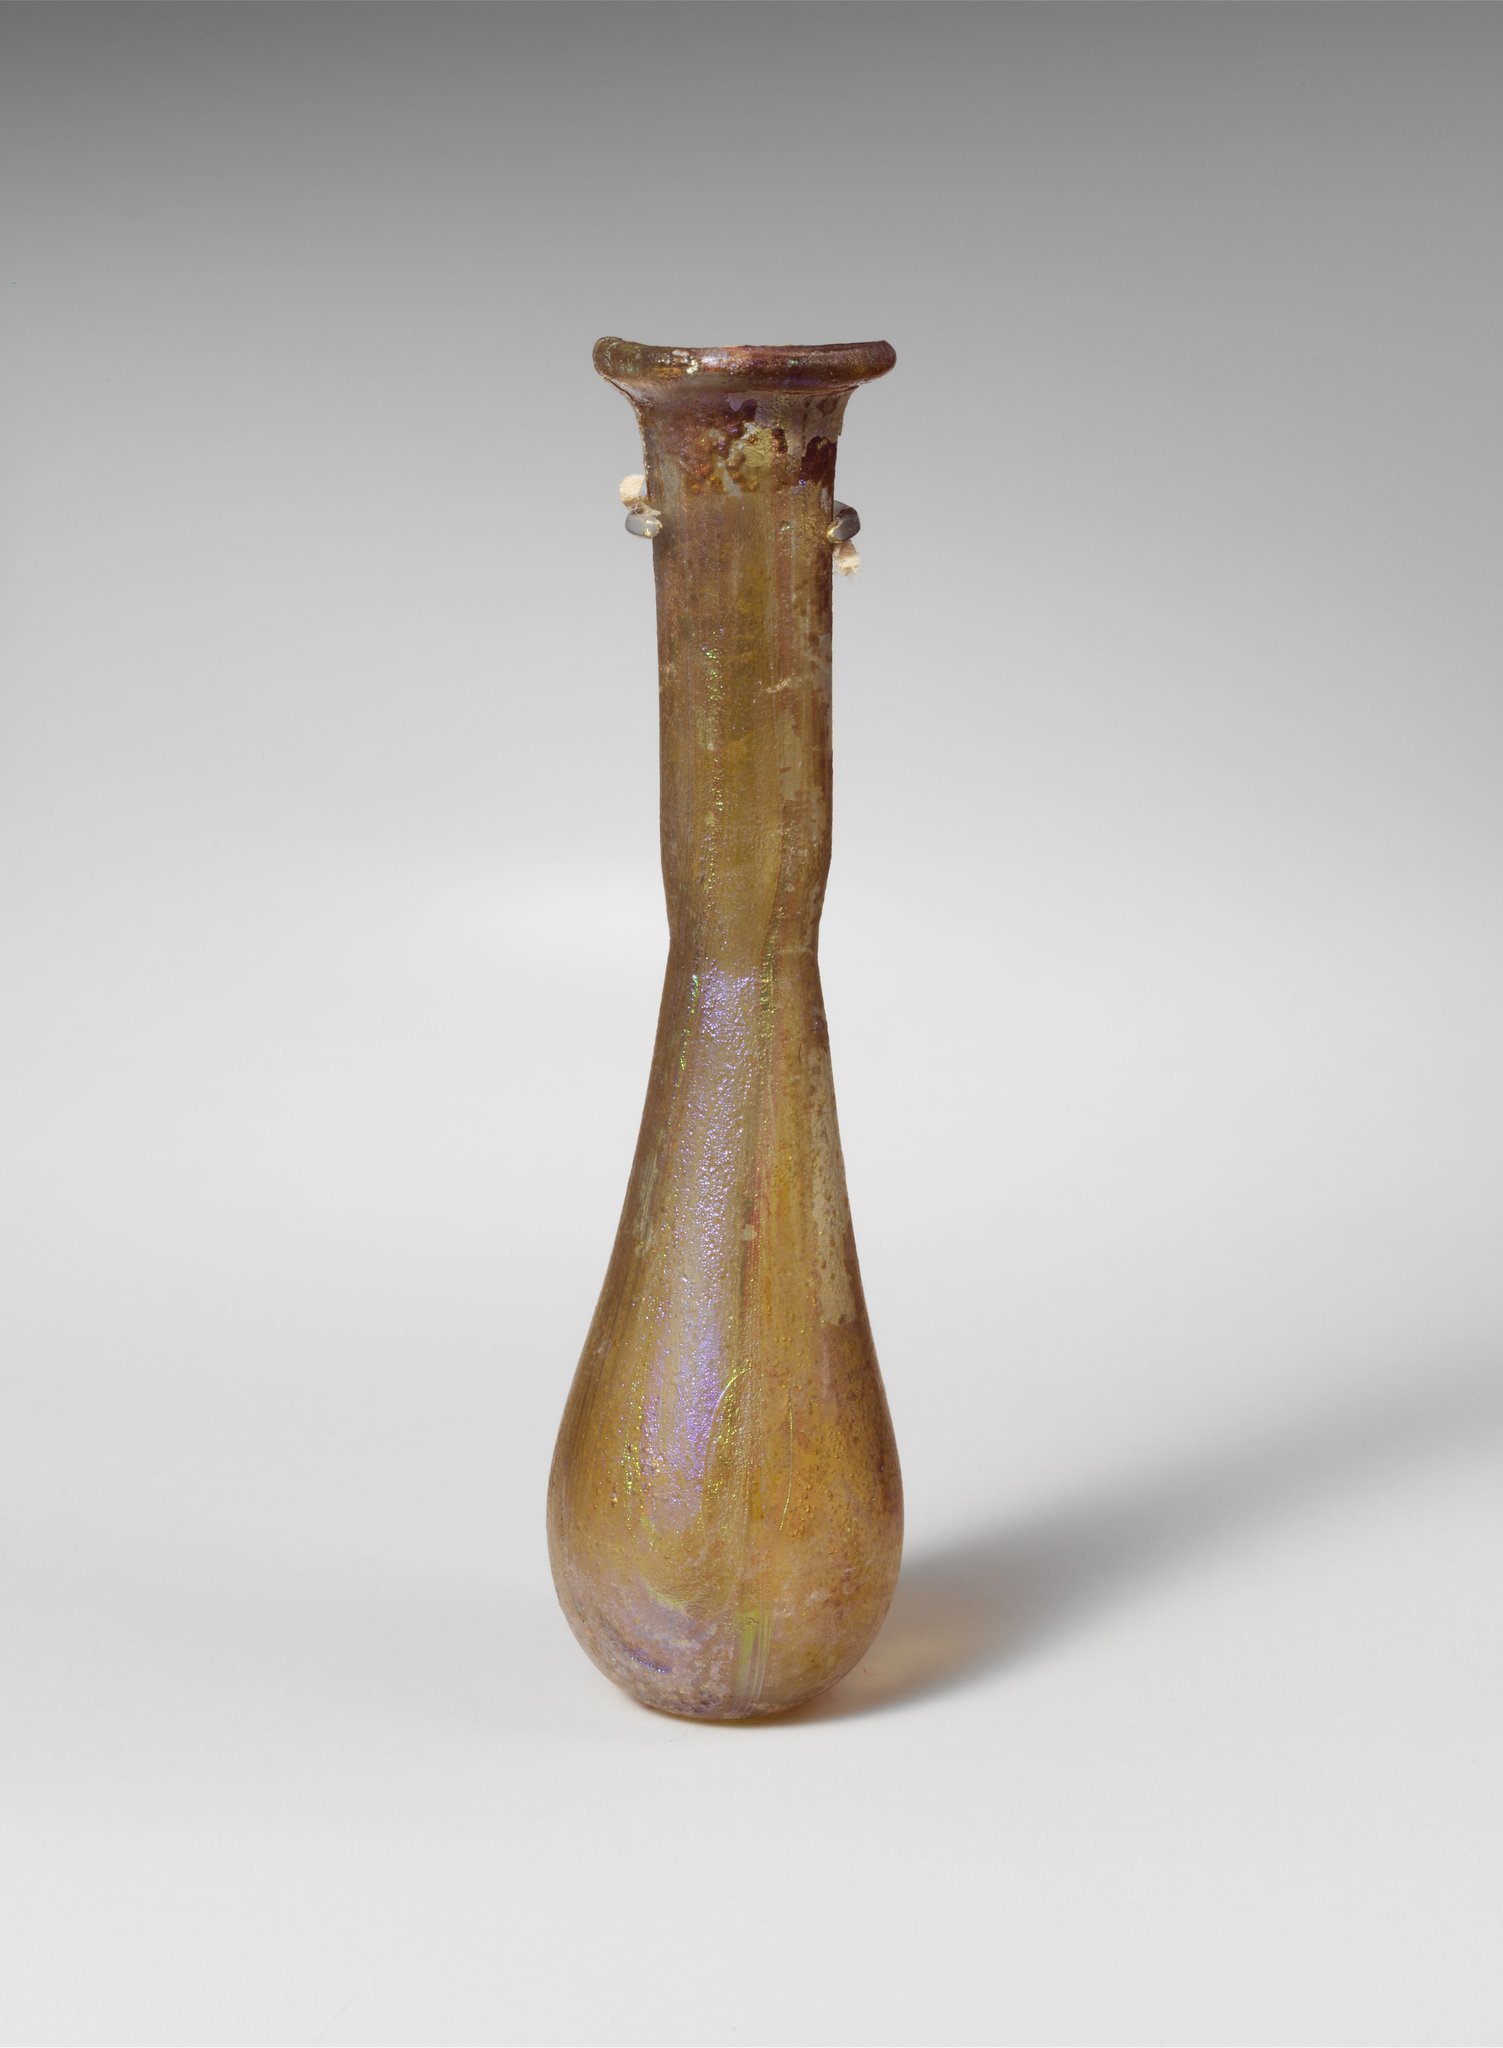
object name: perfume bottle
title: Glass perfume bottle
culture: roman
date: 1-200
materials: glass